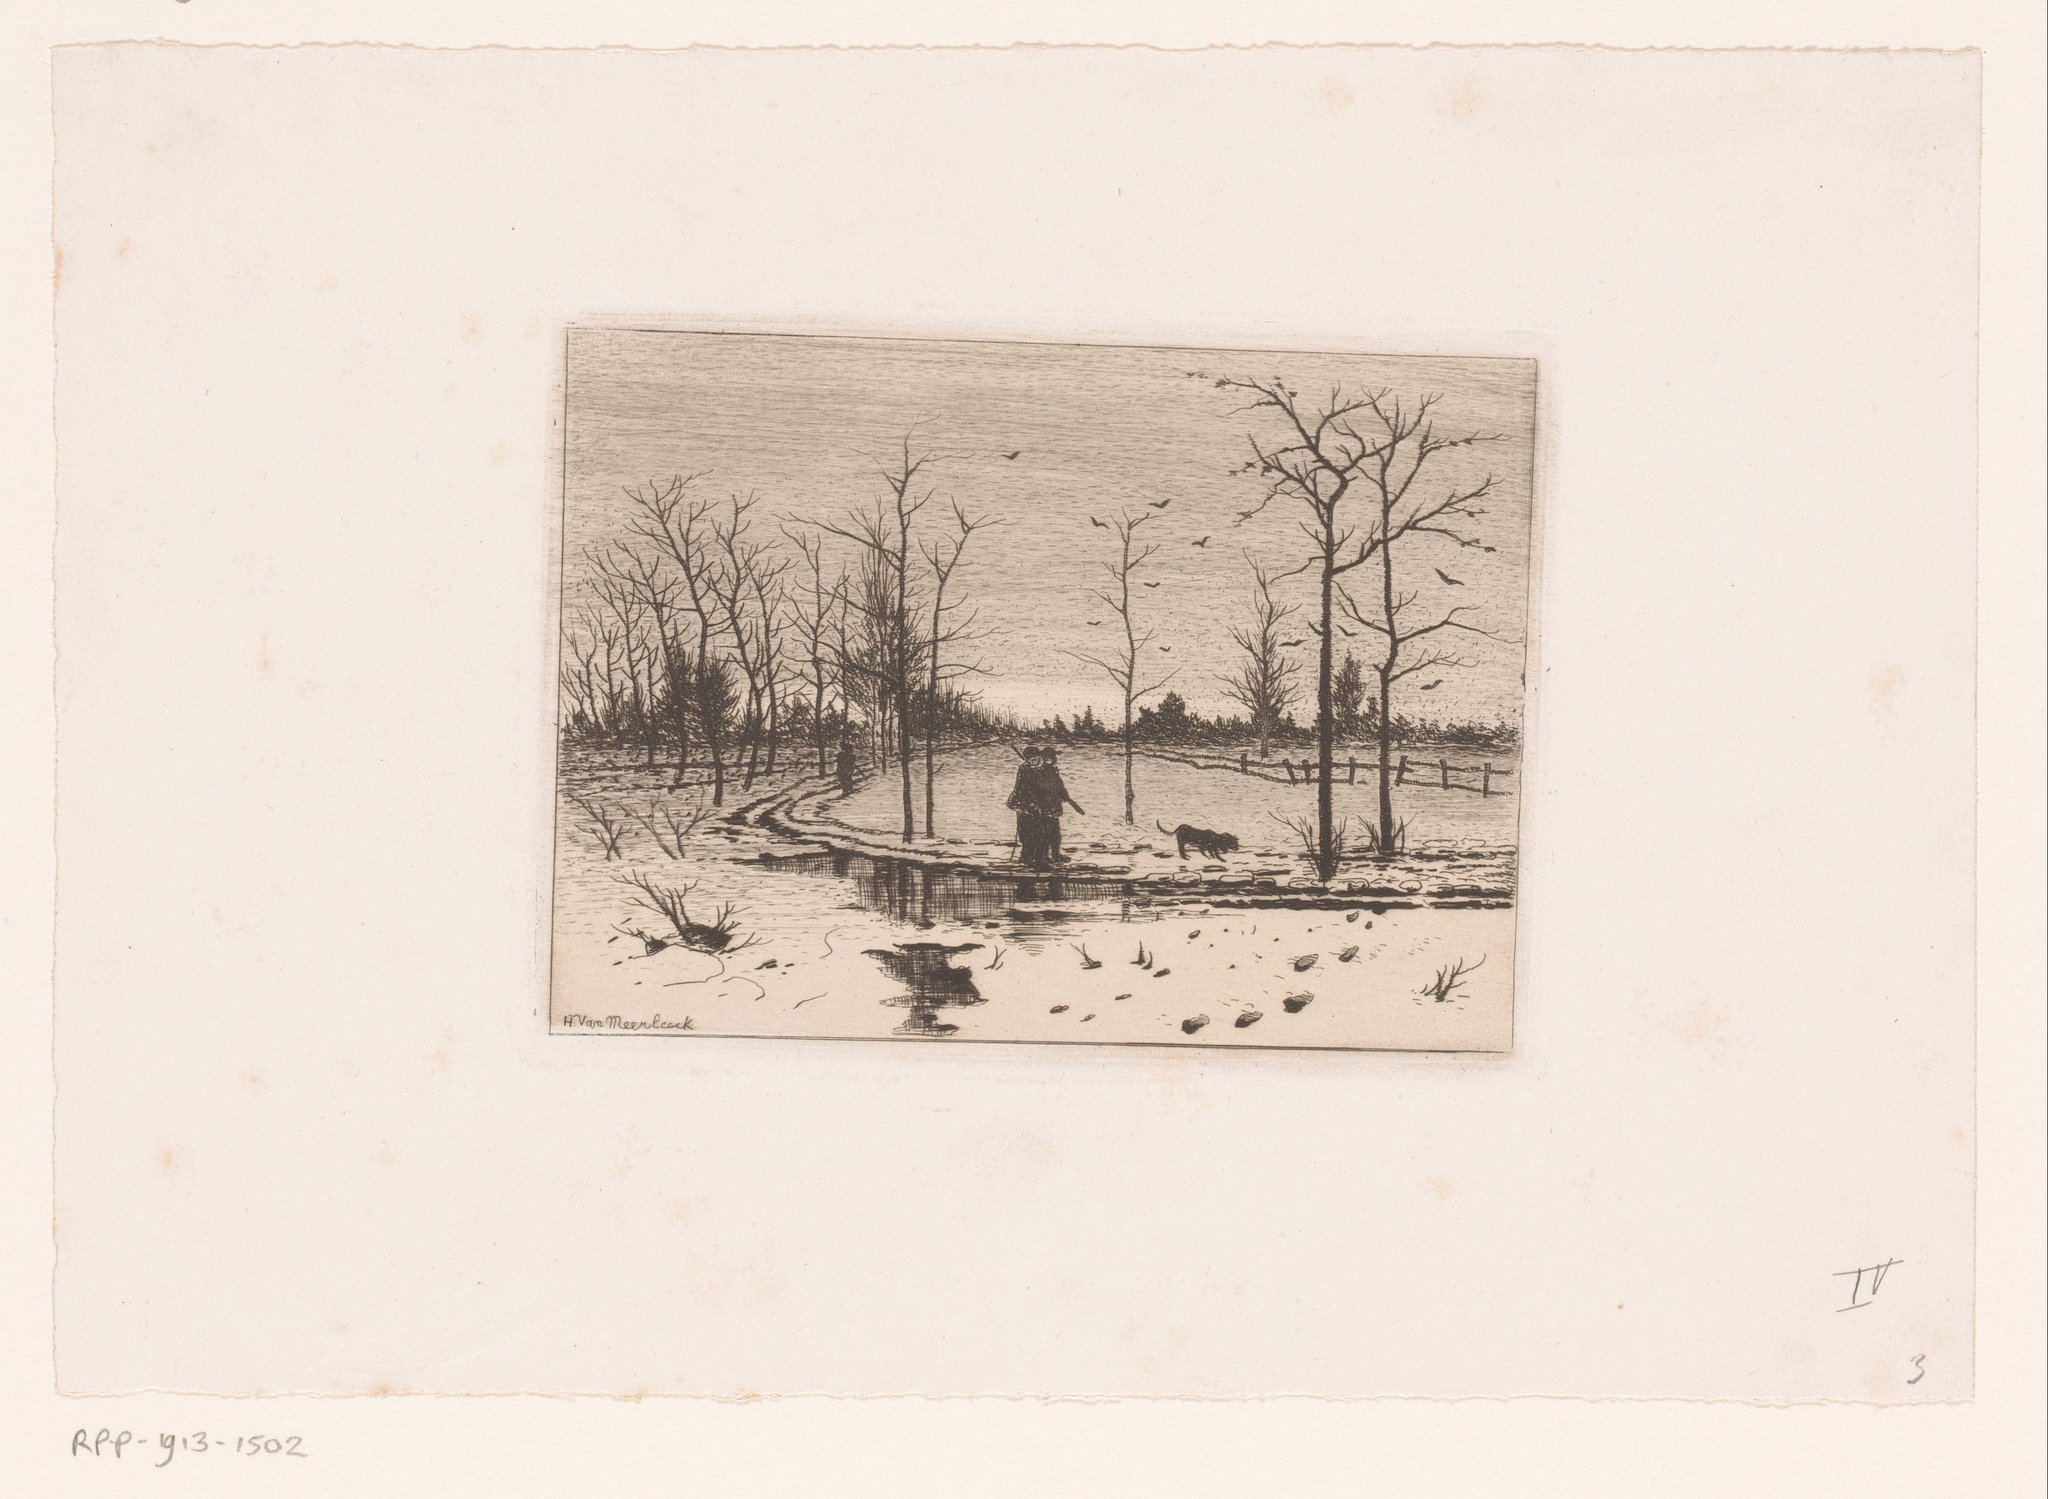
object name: print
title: Winterlandschap met jagers en een hond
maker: h. van meerbeeck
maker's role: print maker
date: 1850-1913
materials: paper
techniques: etching, intaglio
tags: hunters hunting (n.b.: in 1988-1990 this notation denoted the concept of 43c11421 'hunters resting during the hunt'), winter landscape; landscape symbolizing winter (the four seasons of the year), dog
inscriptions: collector's mark: Lugt 2228